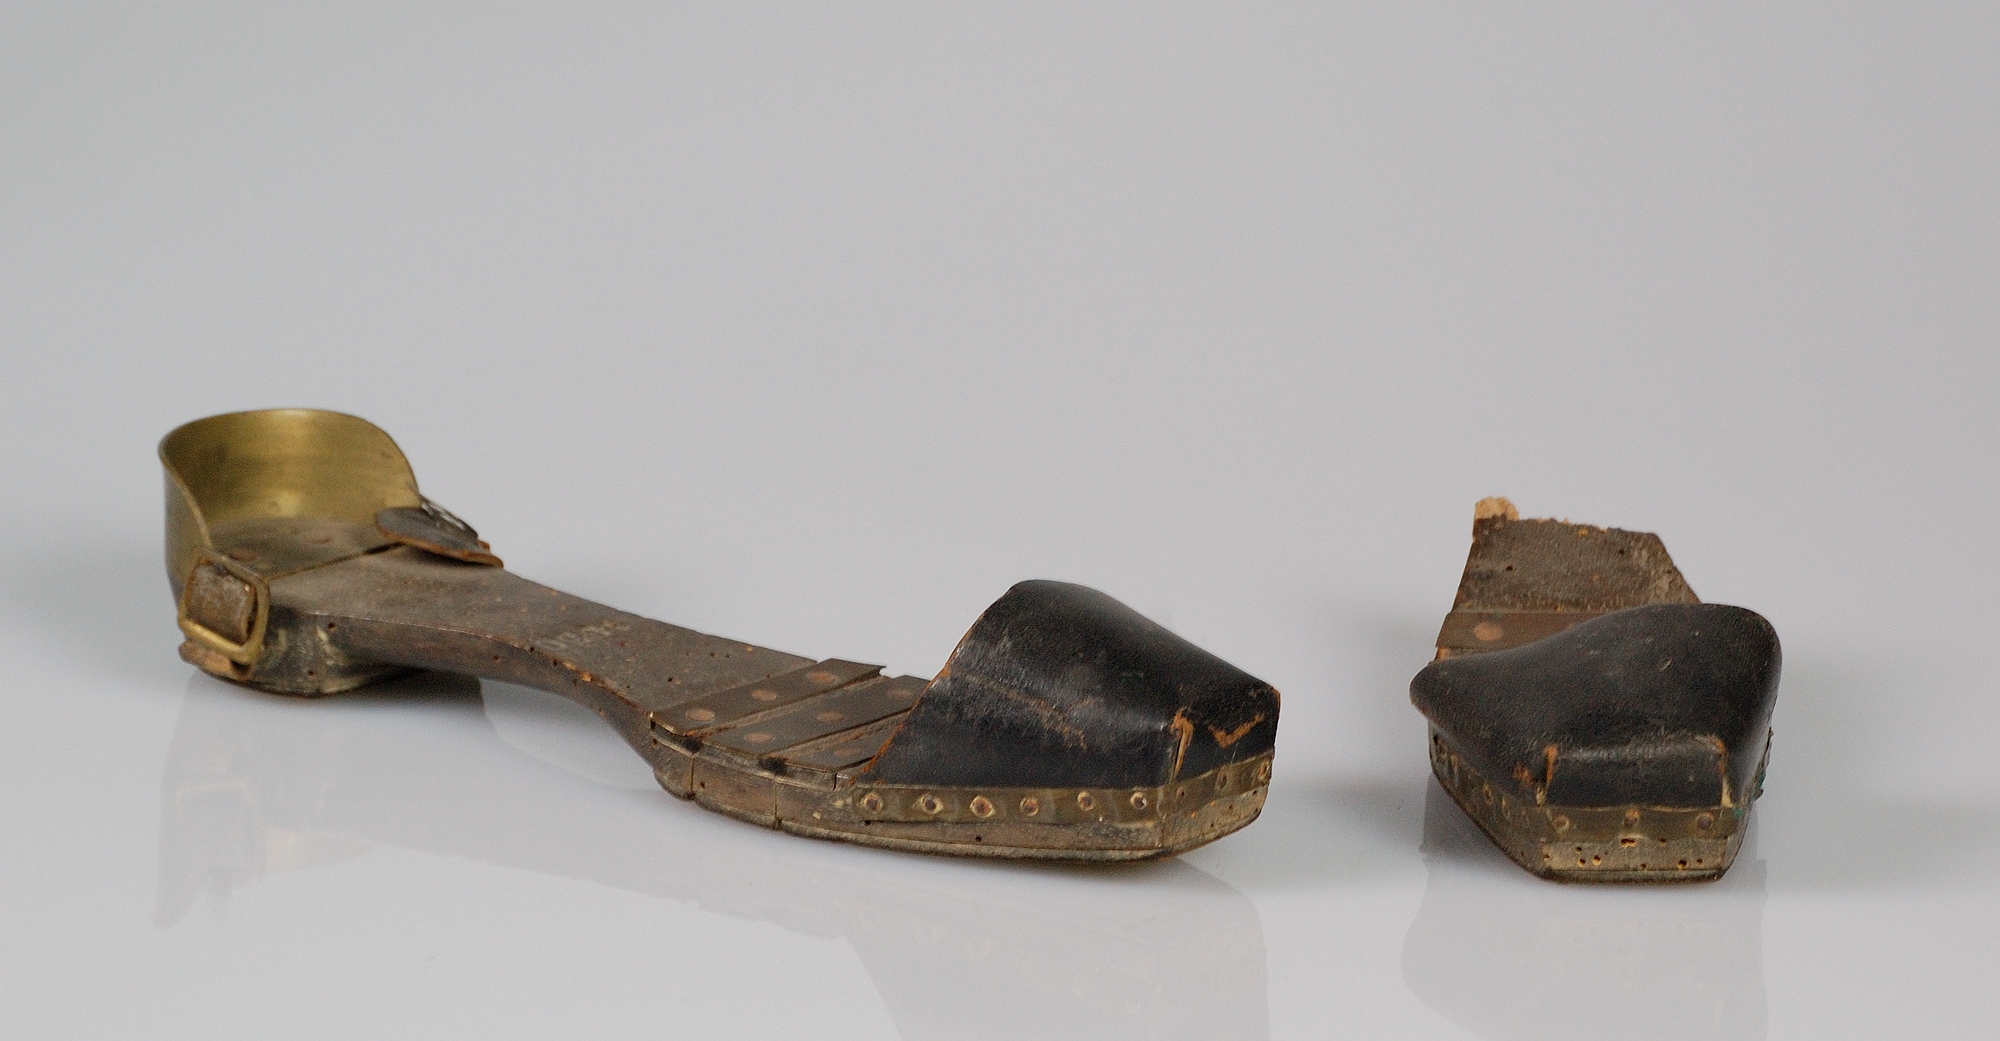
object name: patten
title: Pattens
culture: american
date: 1826-1850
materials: leather, metal, wood